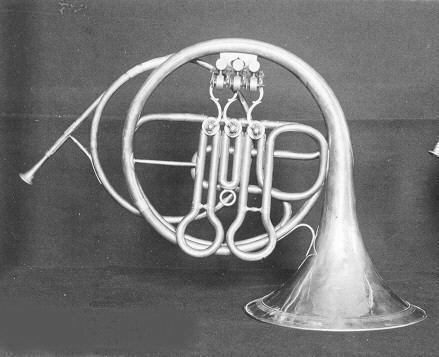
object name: valve horn in b flat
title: Valve Horn in B-flat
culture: italian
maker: ferdinando roth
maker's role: maker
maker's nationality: italian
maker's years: 1815-1898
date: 1870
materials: brass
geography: italy